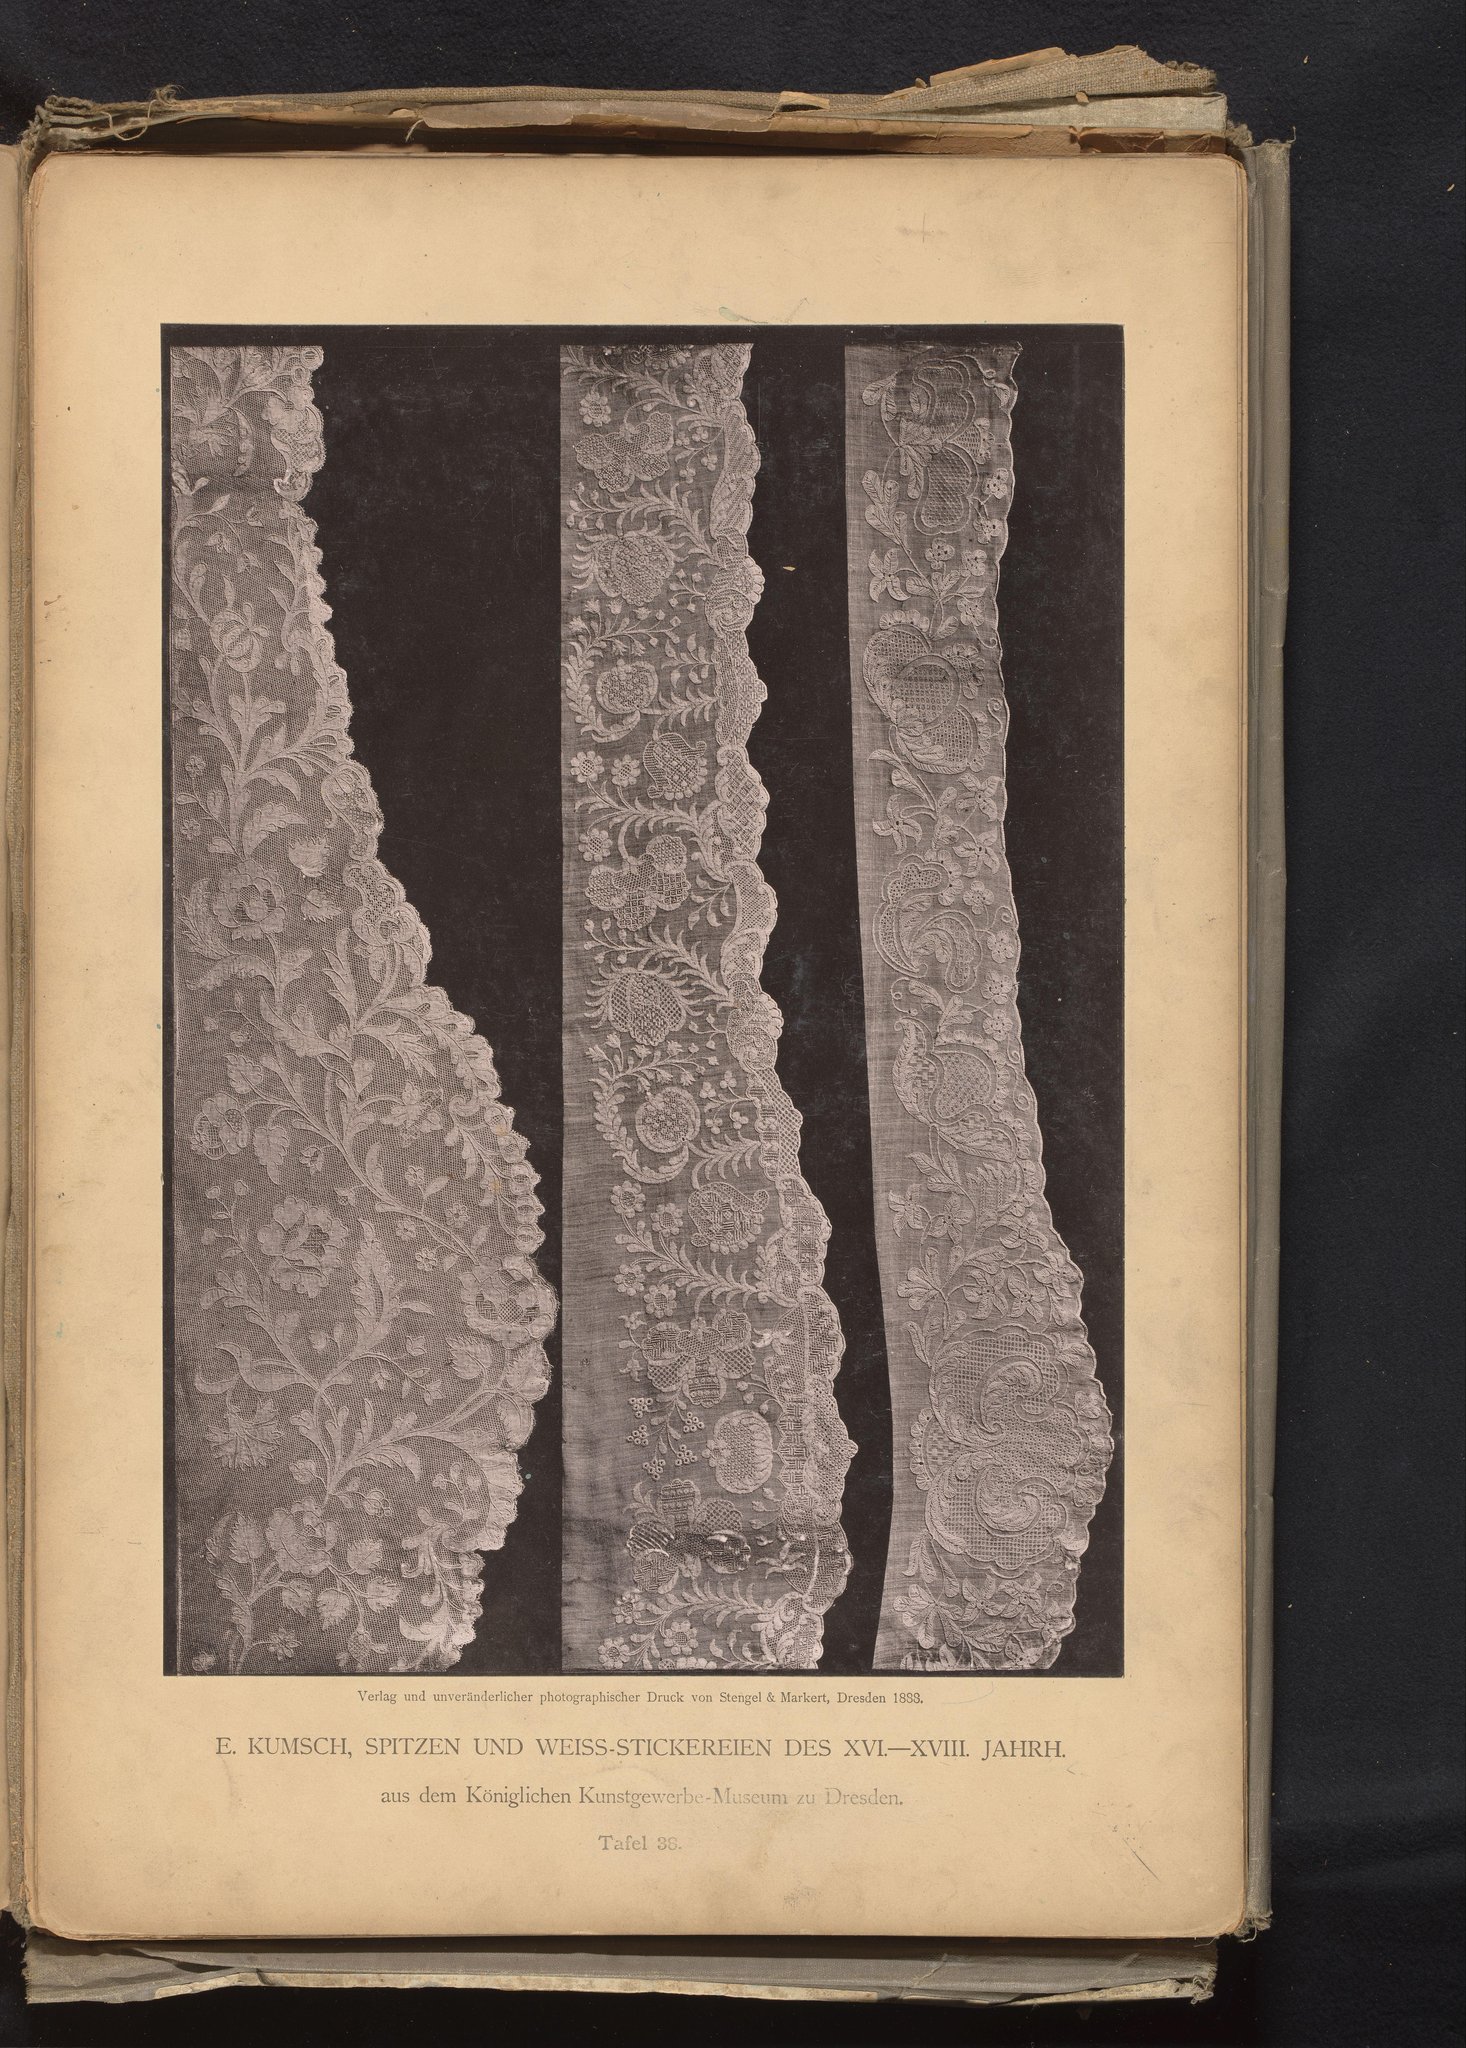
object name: photomechanical print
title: Drie stroken Duits kant uit circa 1770, uit de collectie van het Kunstgewerbemuseum in Dresden, Duitsland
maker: Anonymous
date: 1888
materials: paper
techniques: photograph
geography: dresden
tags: lace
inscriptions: inscription: ‘E. KUMSCH, SPITZEN UND WEISS-STICKEREIEN DES XVI.-XVIII. JAHRH./ aus dem Königlichen Kunstgewerbe-Museum zu Dresden’, number: ‘Tafel 38.’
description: Deze prent maakt deel uit van een omslag met 49 prenten en een lijst van afbeeldingen.